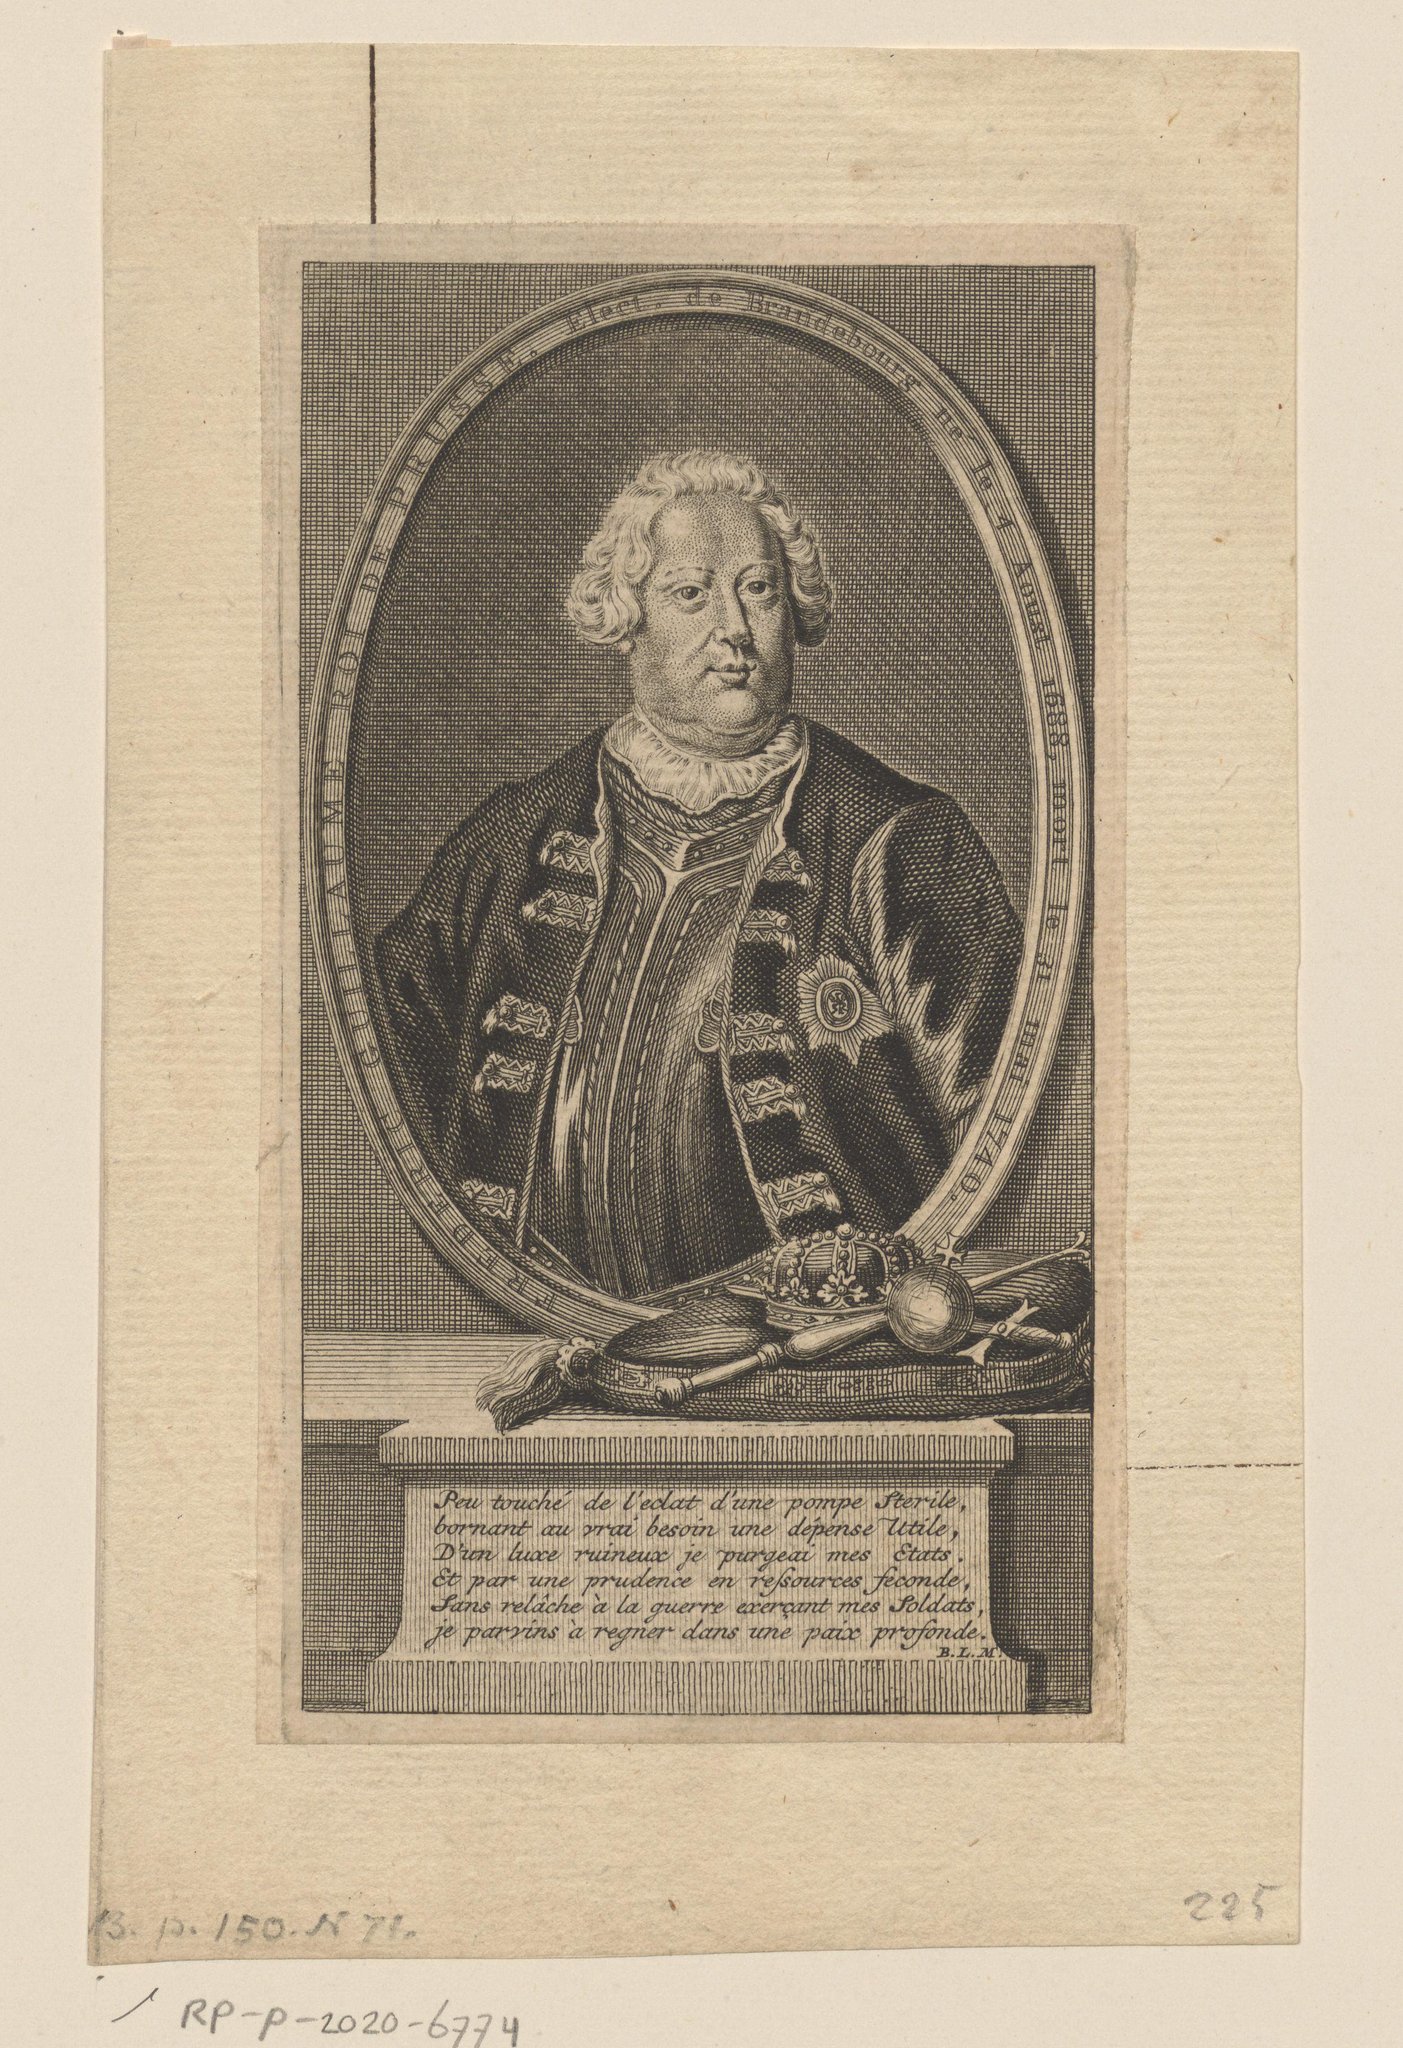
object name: print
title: Portret van Frederik Willem I van Pruisen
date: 1740-1799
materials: paper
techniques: etching, snipping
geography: france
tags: berlin, crown (symbol of sovereignty), orb (symbol of sovereignty; sphere with cross on top), sceptre, staff (symbol of sovereignty), ornament ~ medallion, historical persons, king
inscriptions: monogram: ‘B.L.M.’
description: Met zesregelig vers in het Frans onder het portret.